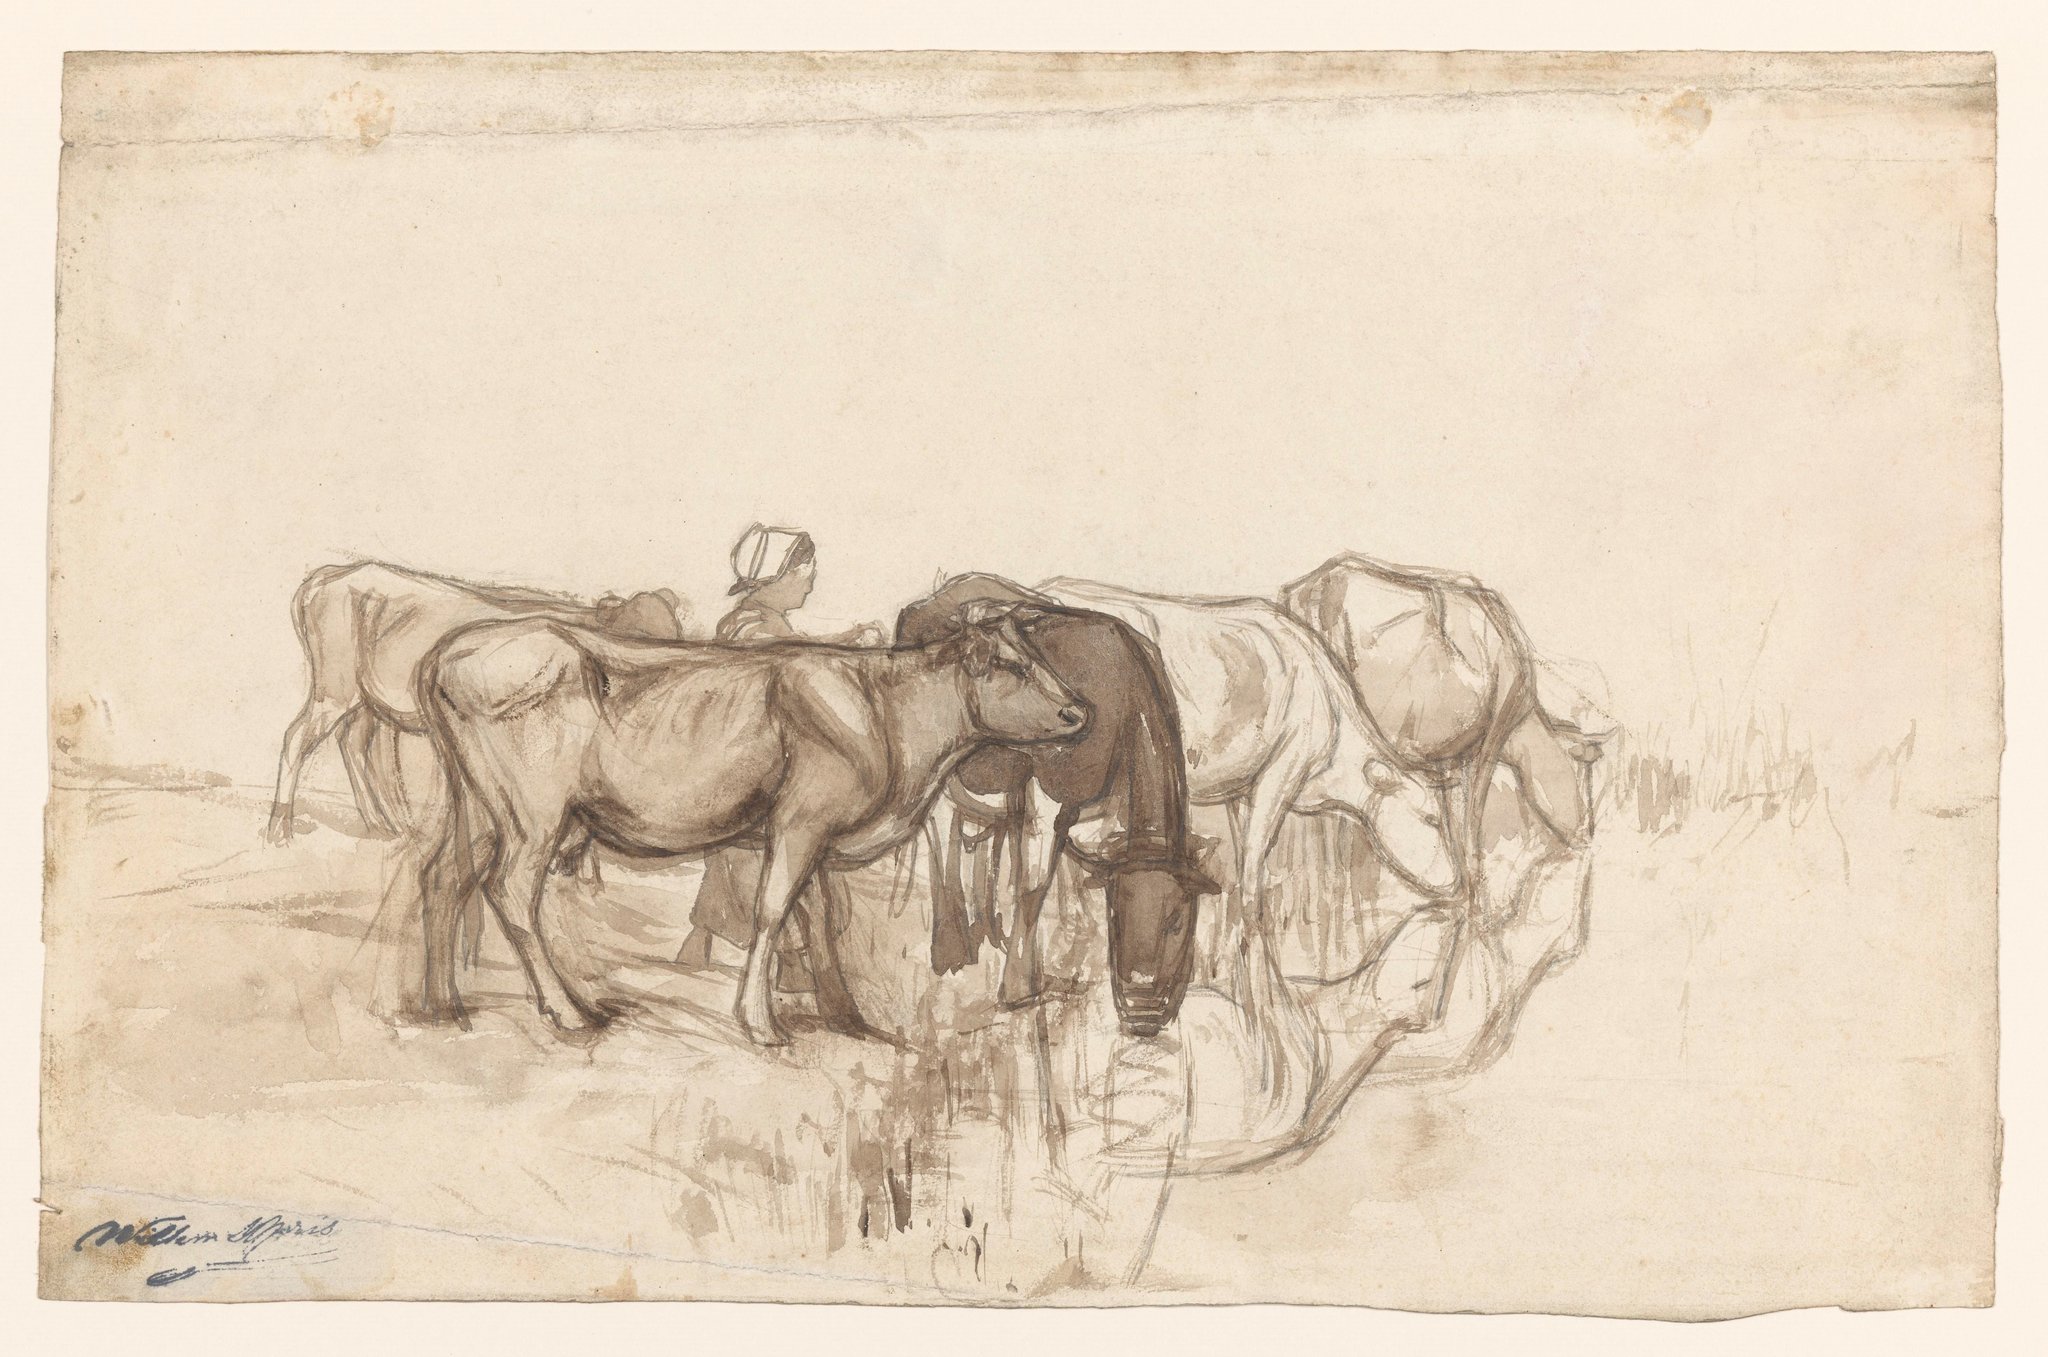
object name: drawing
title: Vijf koeien drinkende aan een slootkant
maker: willem maris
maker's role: draughtsman, painter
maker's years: 1844-1910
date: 1854-1910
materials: chalk, paper, pencil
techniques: brush, pen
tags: cow